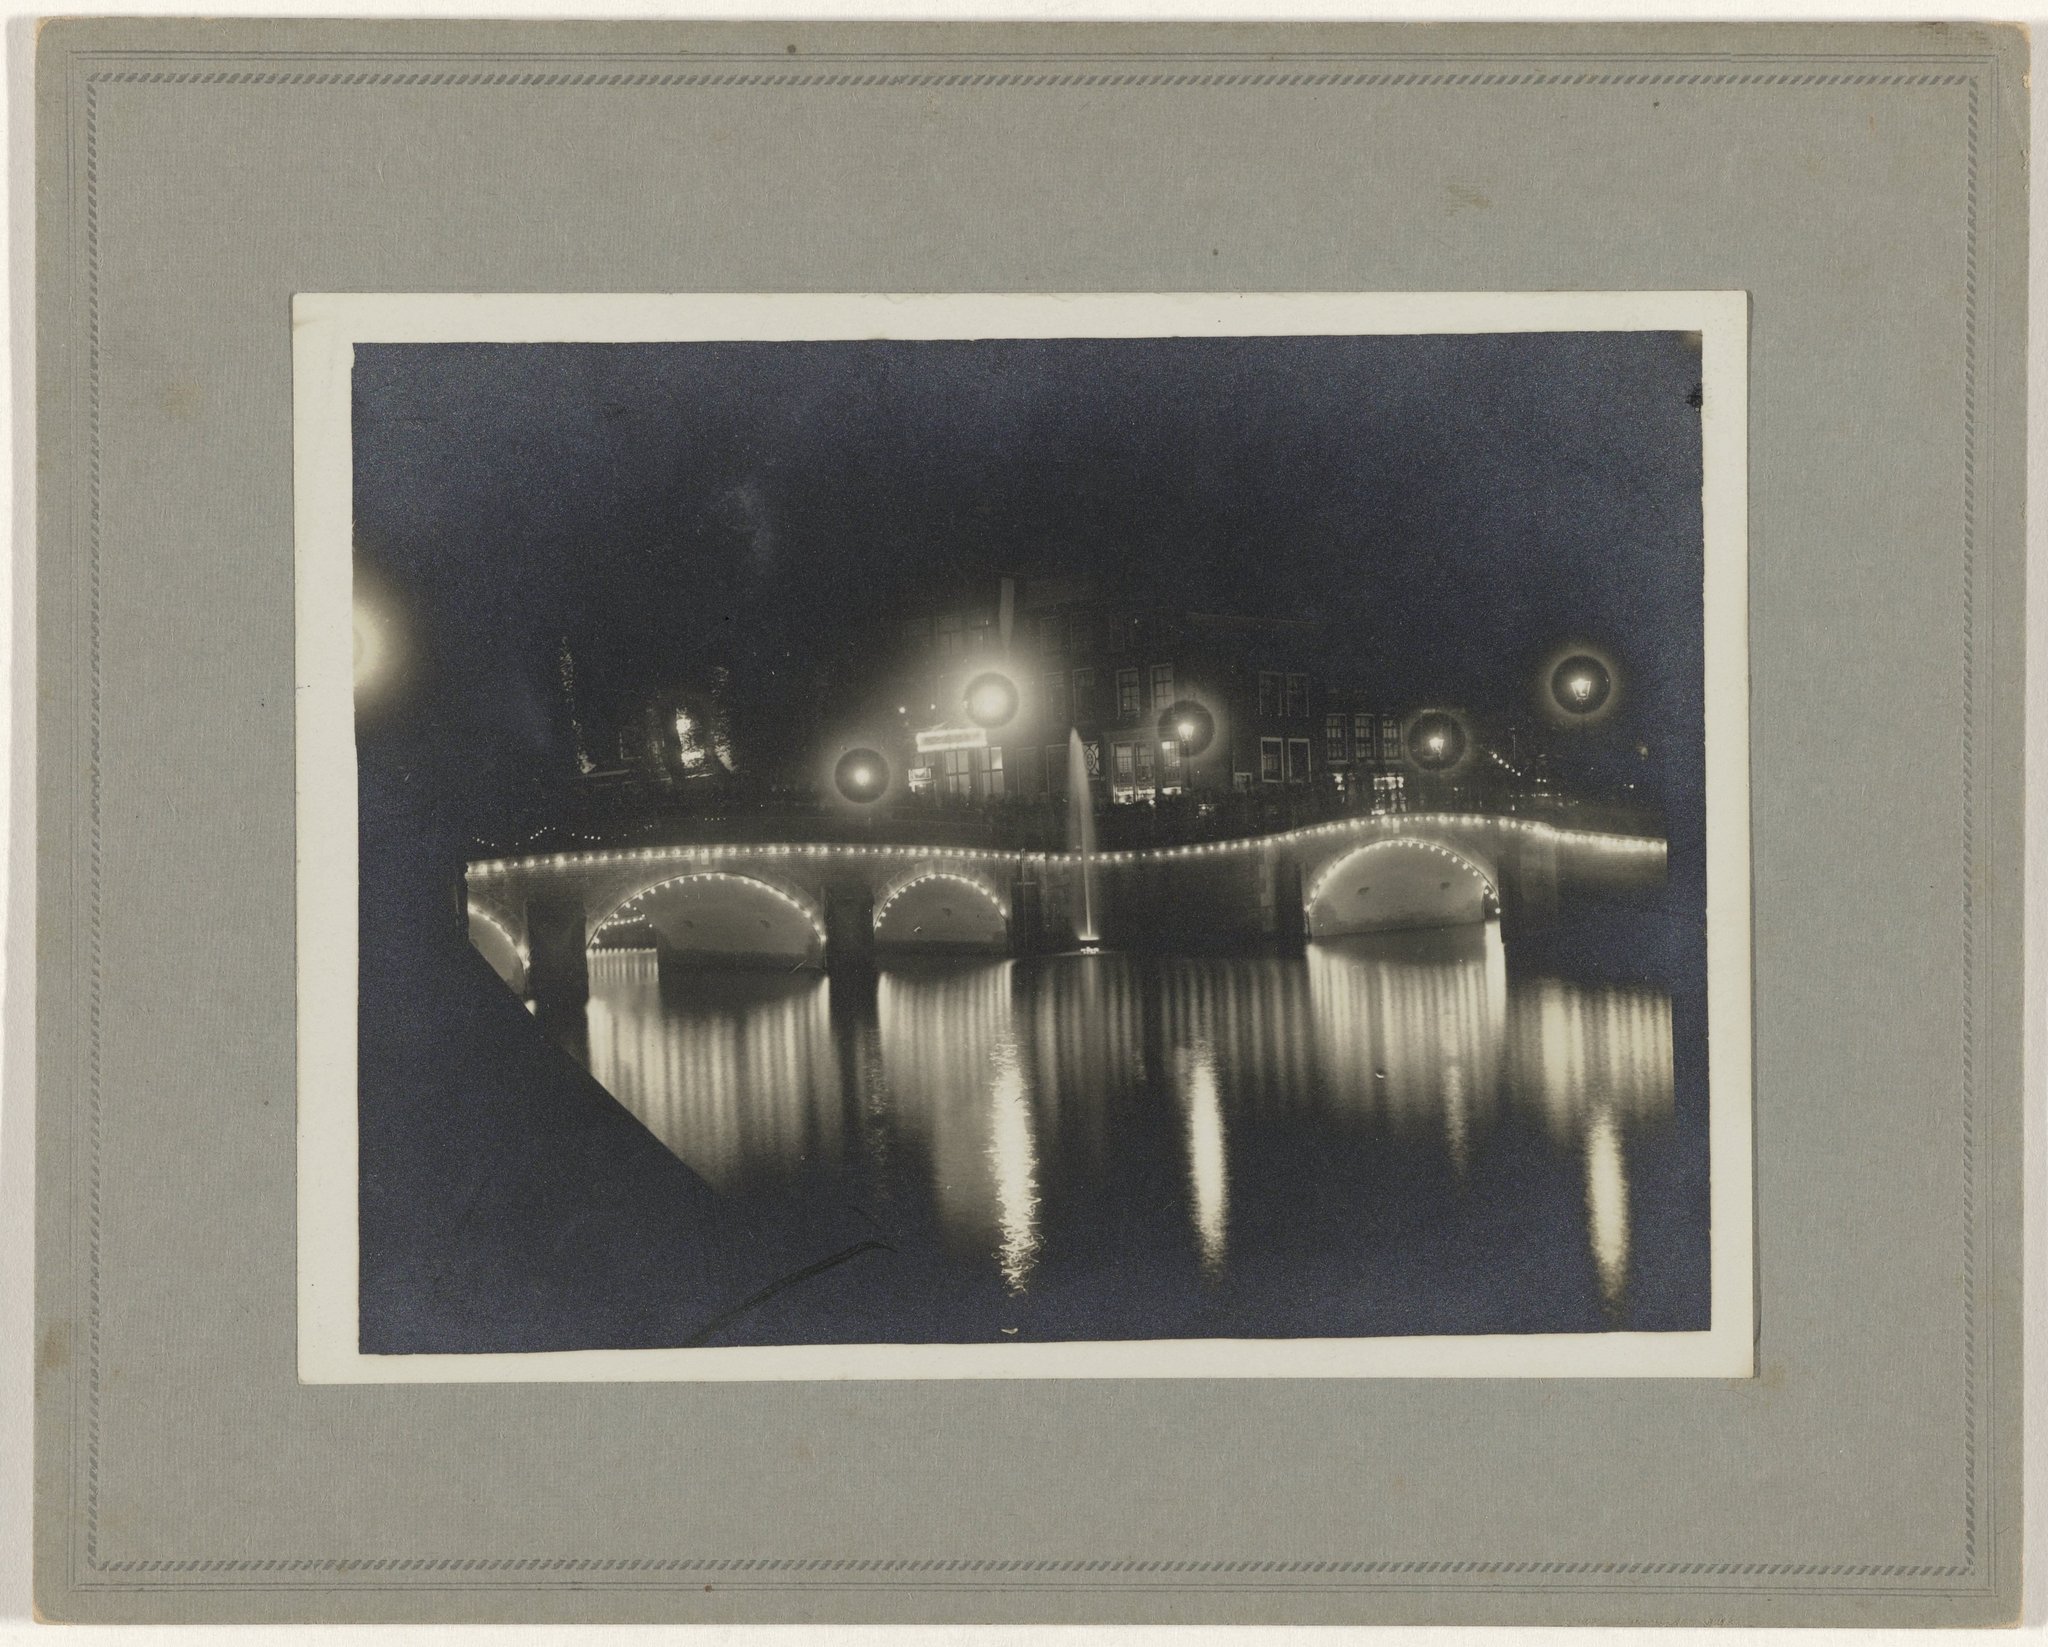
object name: photograph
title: Verlichte brug te Amsterdam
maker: Anonymous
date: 1923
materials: cardboard, photographic support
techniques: gelatin silver print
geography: amsterdam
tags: the hague, wilhelmina of the netherlands, public festivities at other royal events, not meant or mentioned above (+ illumination, fire-works ~ festive activities), canal, bridge in city across river, canal, etc., amsterdam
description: Illuminatie op de gracht te Amsterdam bij 25-jarig regeringsjubileum van koningin Wilhelmina, 1923.